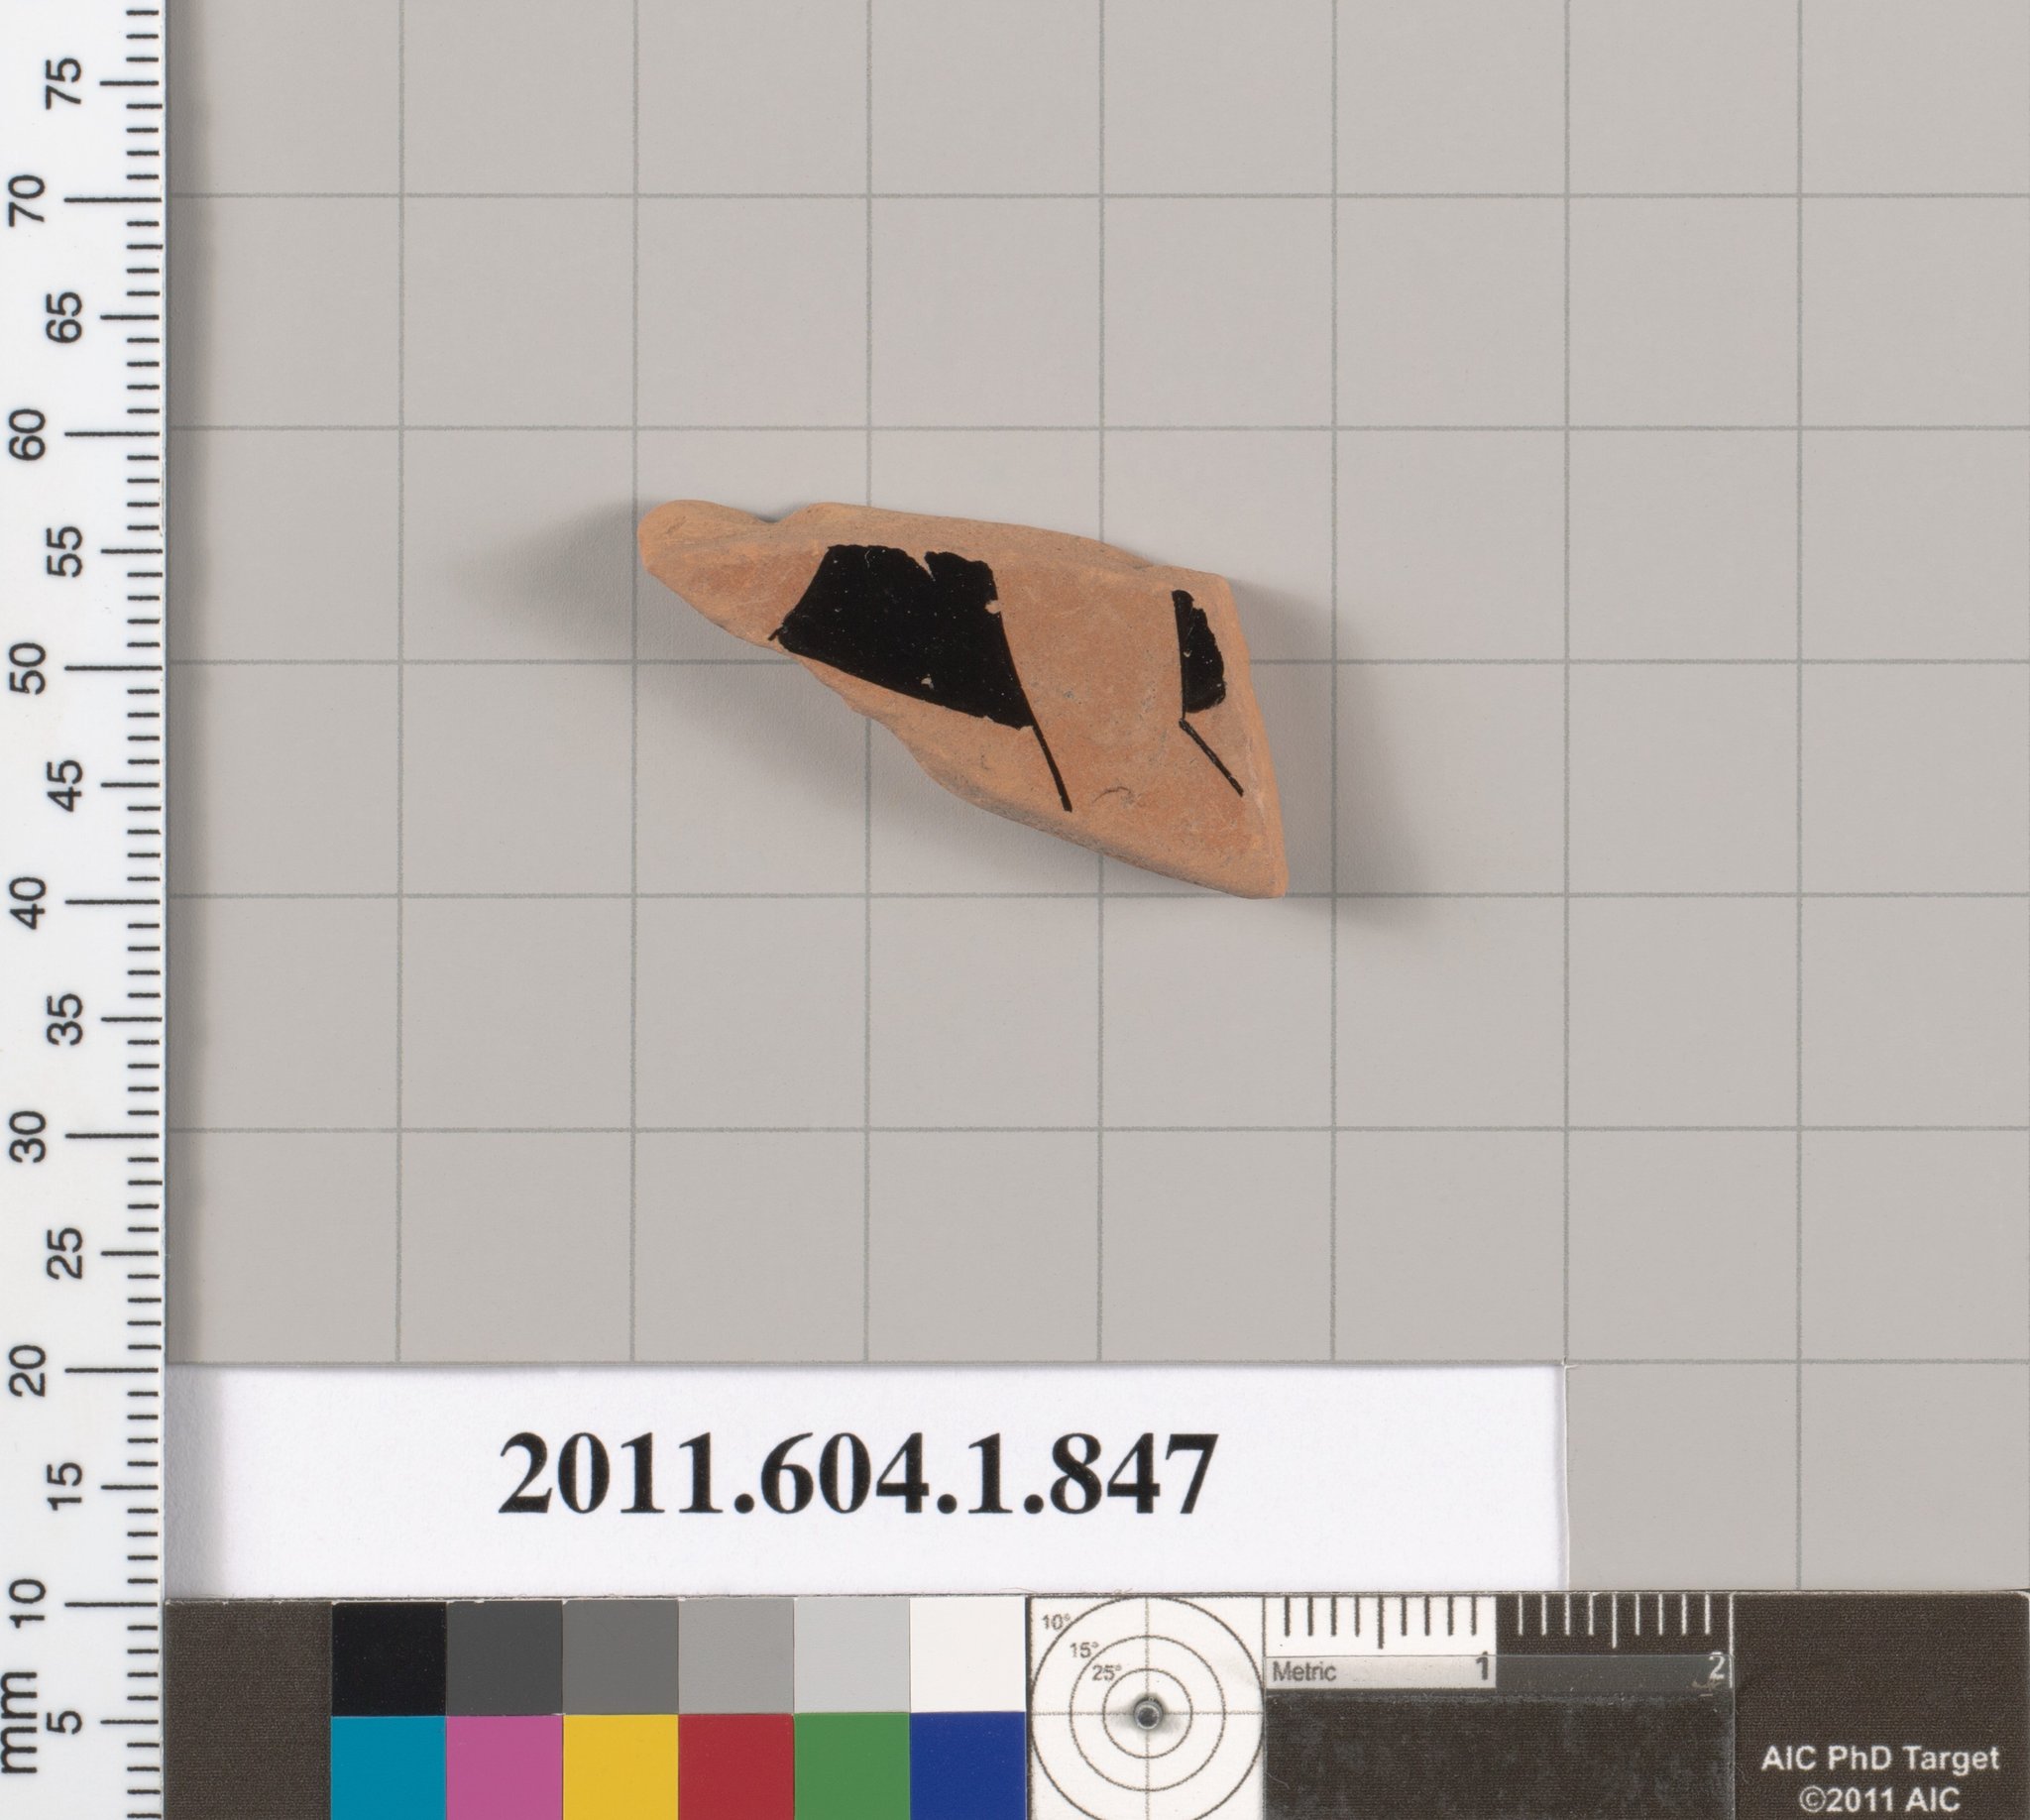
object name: kylix fragment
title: Terracotta fragment of a kylix (drinking cup)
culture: greek, attic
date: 475-451 BCE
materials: terracotta